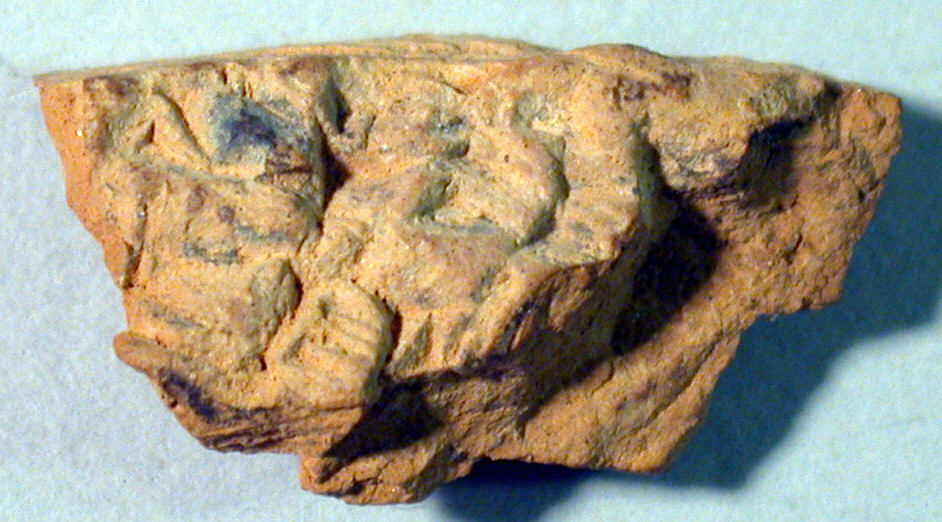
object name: cuneiform tablet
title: Cuneiform tablet: fragment, Ebabbar archive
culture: achaemenid or babylonian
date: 700-301 BCE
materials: clay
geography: mesopotamia